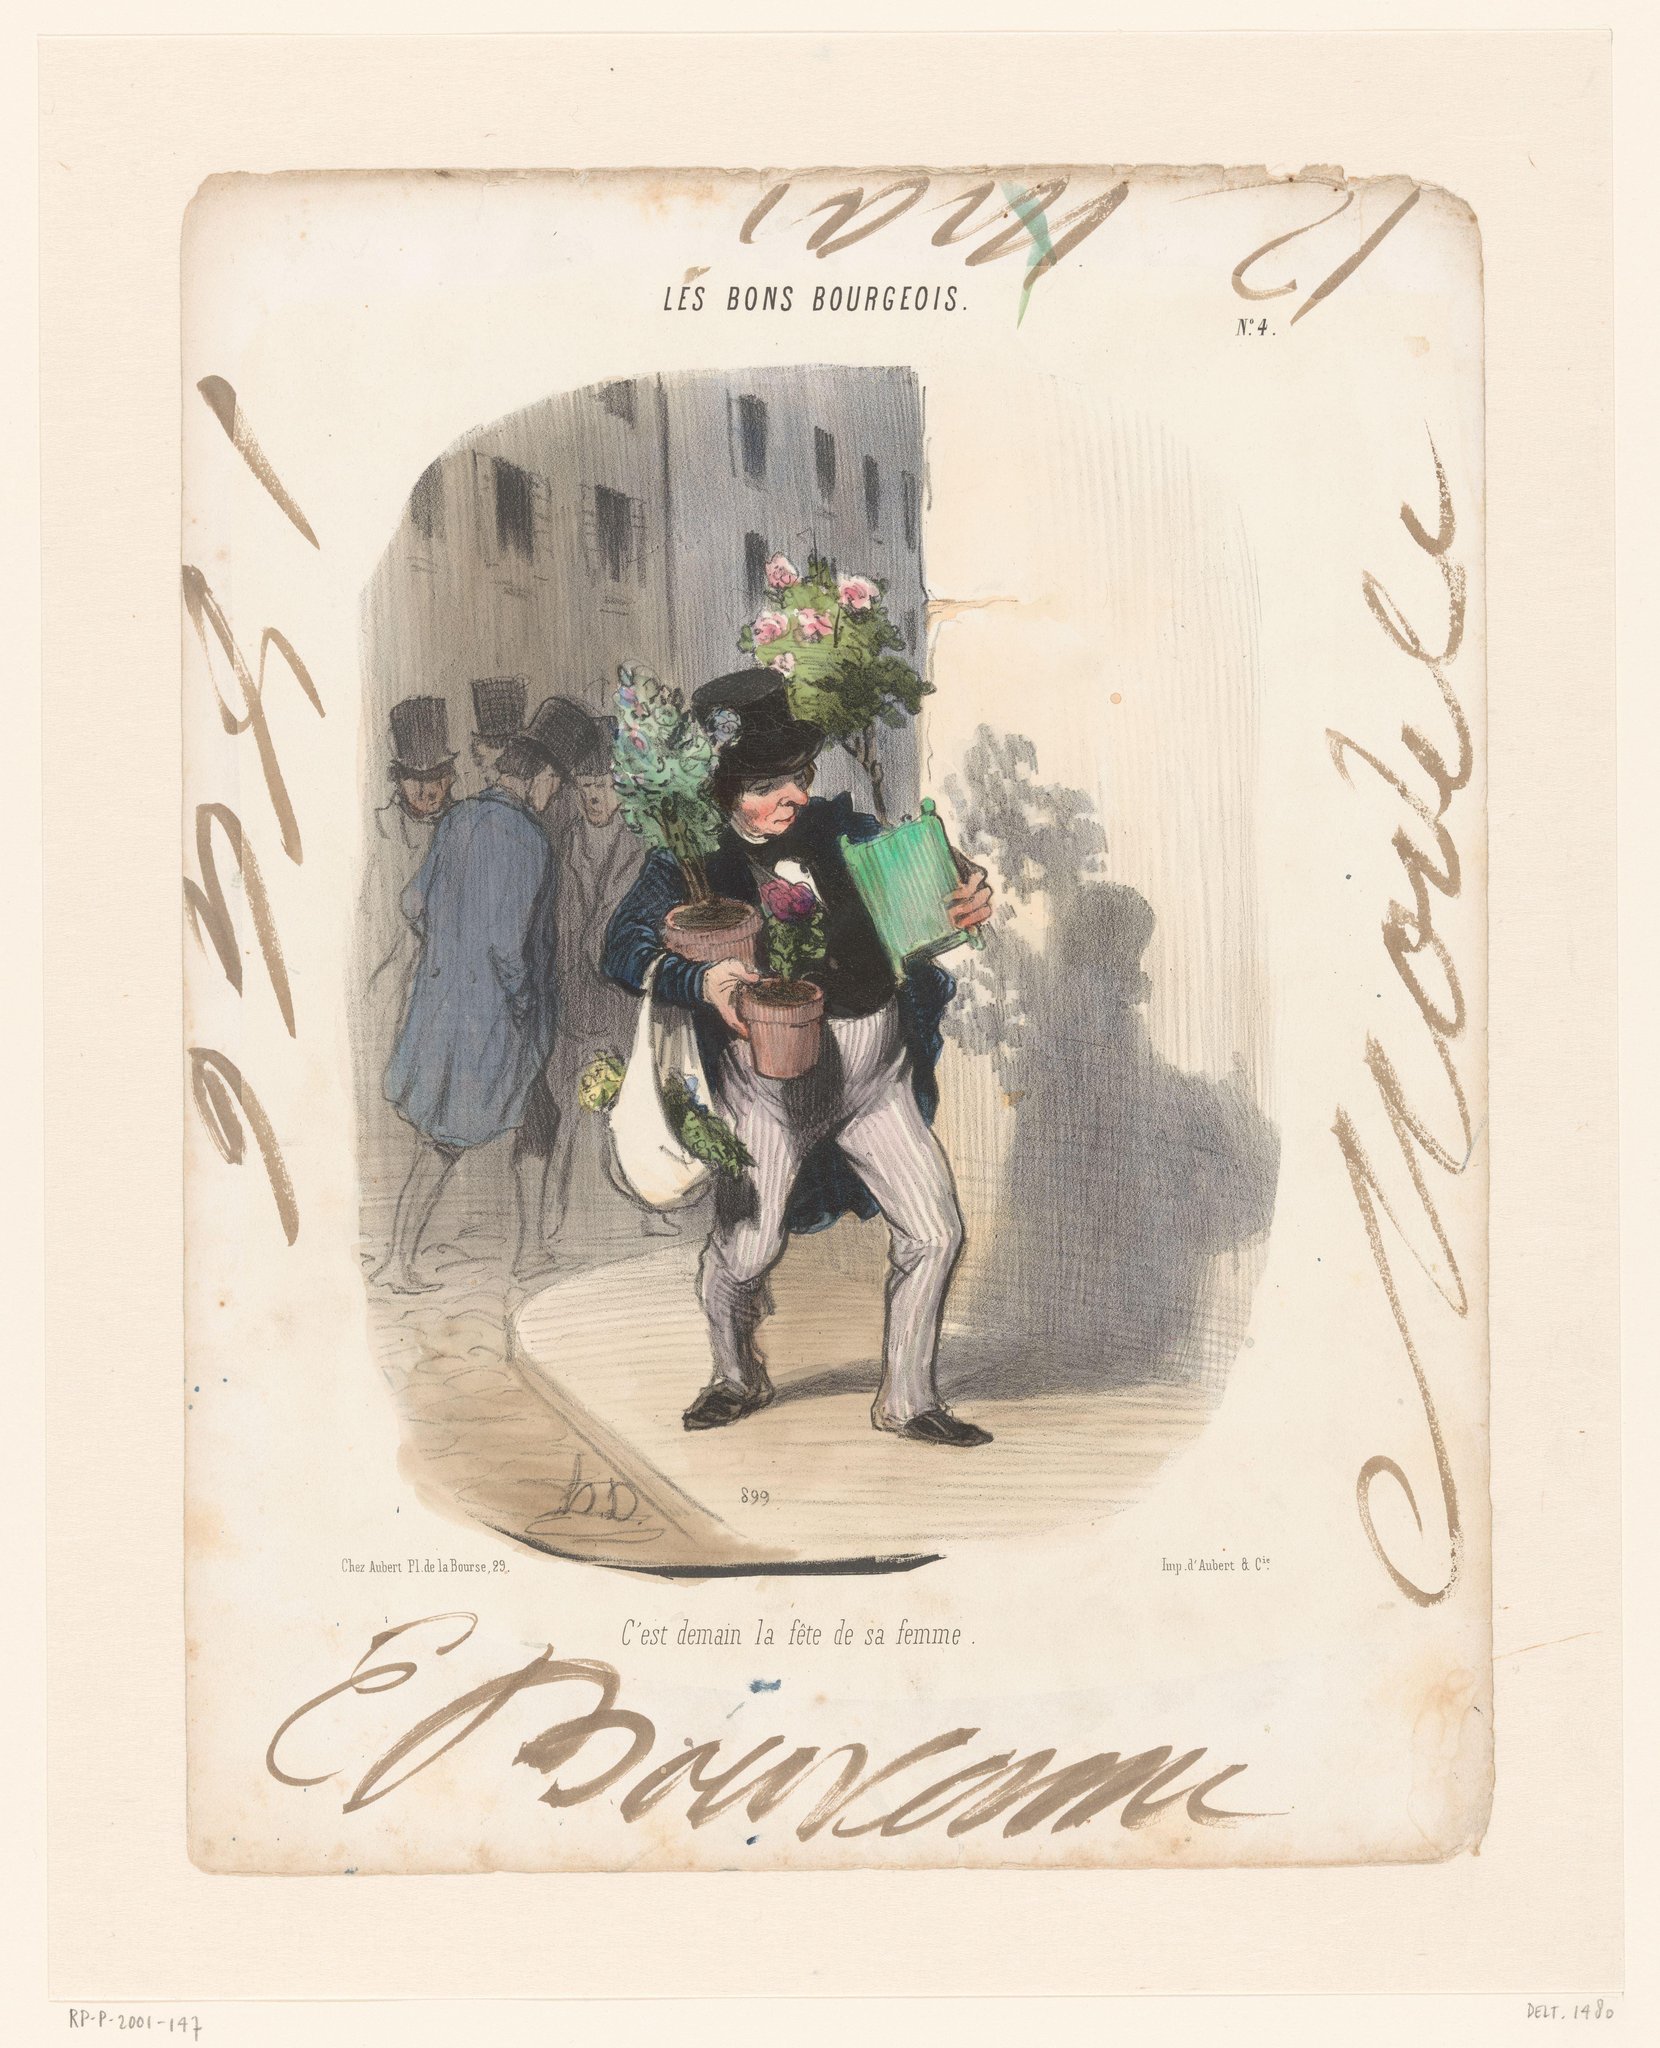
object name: cartoon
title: C'est demain la fête de sa femme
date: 1846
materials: paper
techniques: hand coloring, lithograph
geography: paris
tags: cut flowers; nosegay, bunch of flowers, caricatures (human types), potted plants, presents offered to the beloved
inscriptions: annotation: ‘Modelé 12 Mai 1846 E. Bouvenne’, collector's mark: Lugt 2228a, collector's mark: Lugt 2760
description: De man heeft potten met planten en bloemen gekocht voor de verjaardag van zijn vrouw.